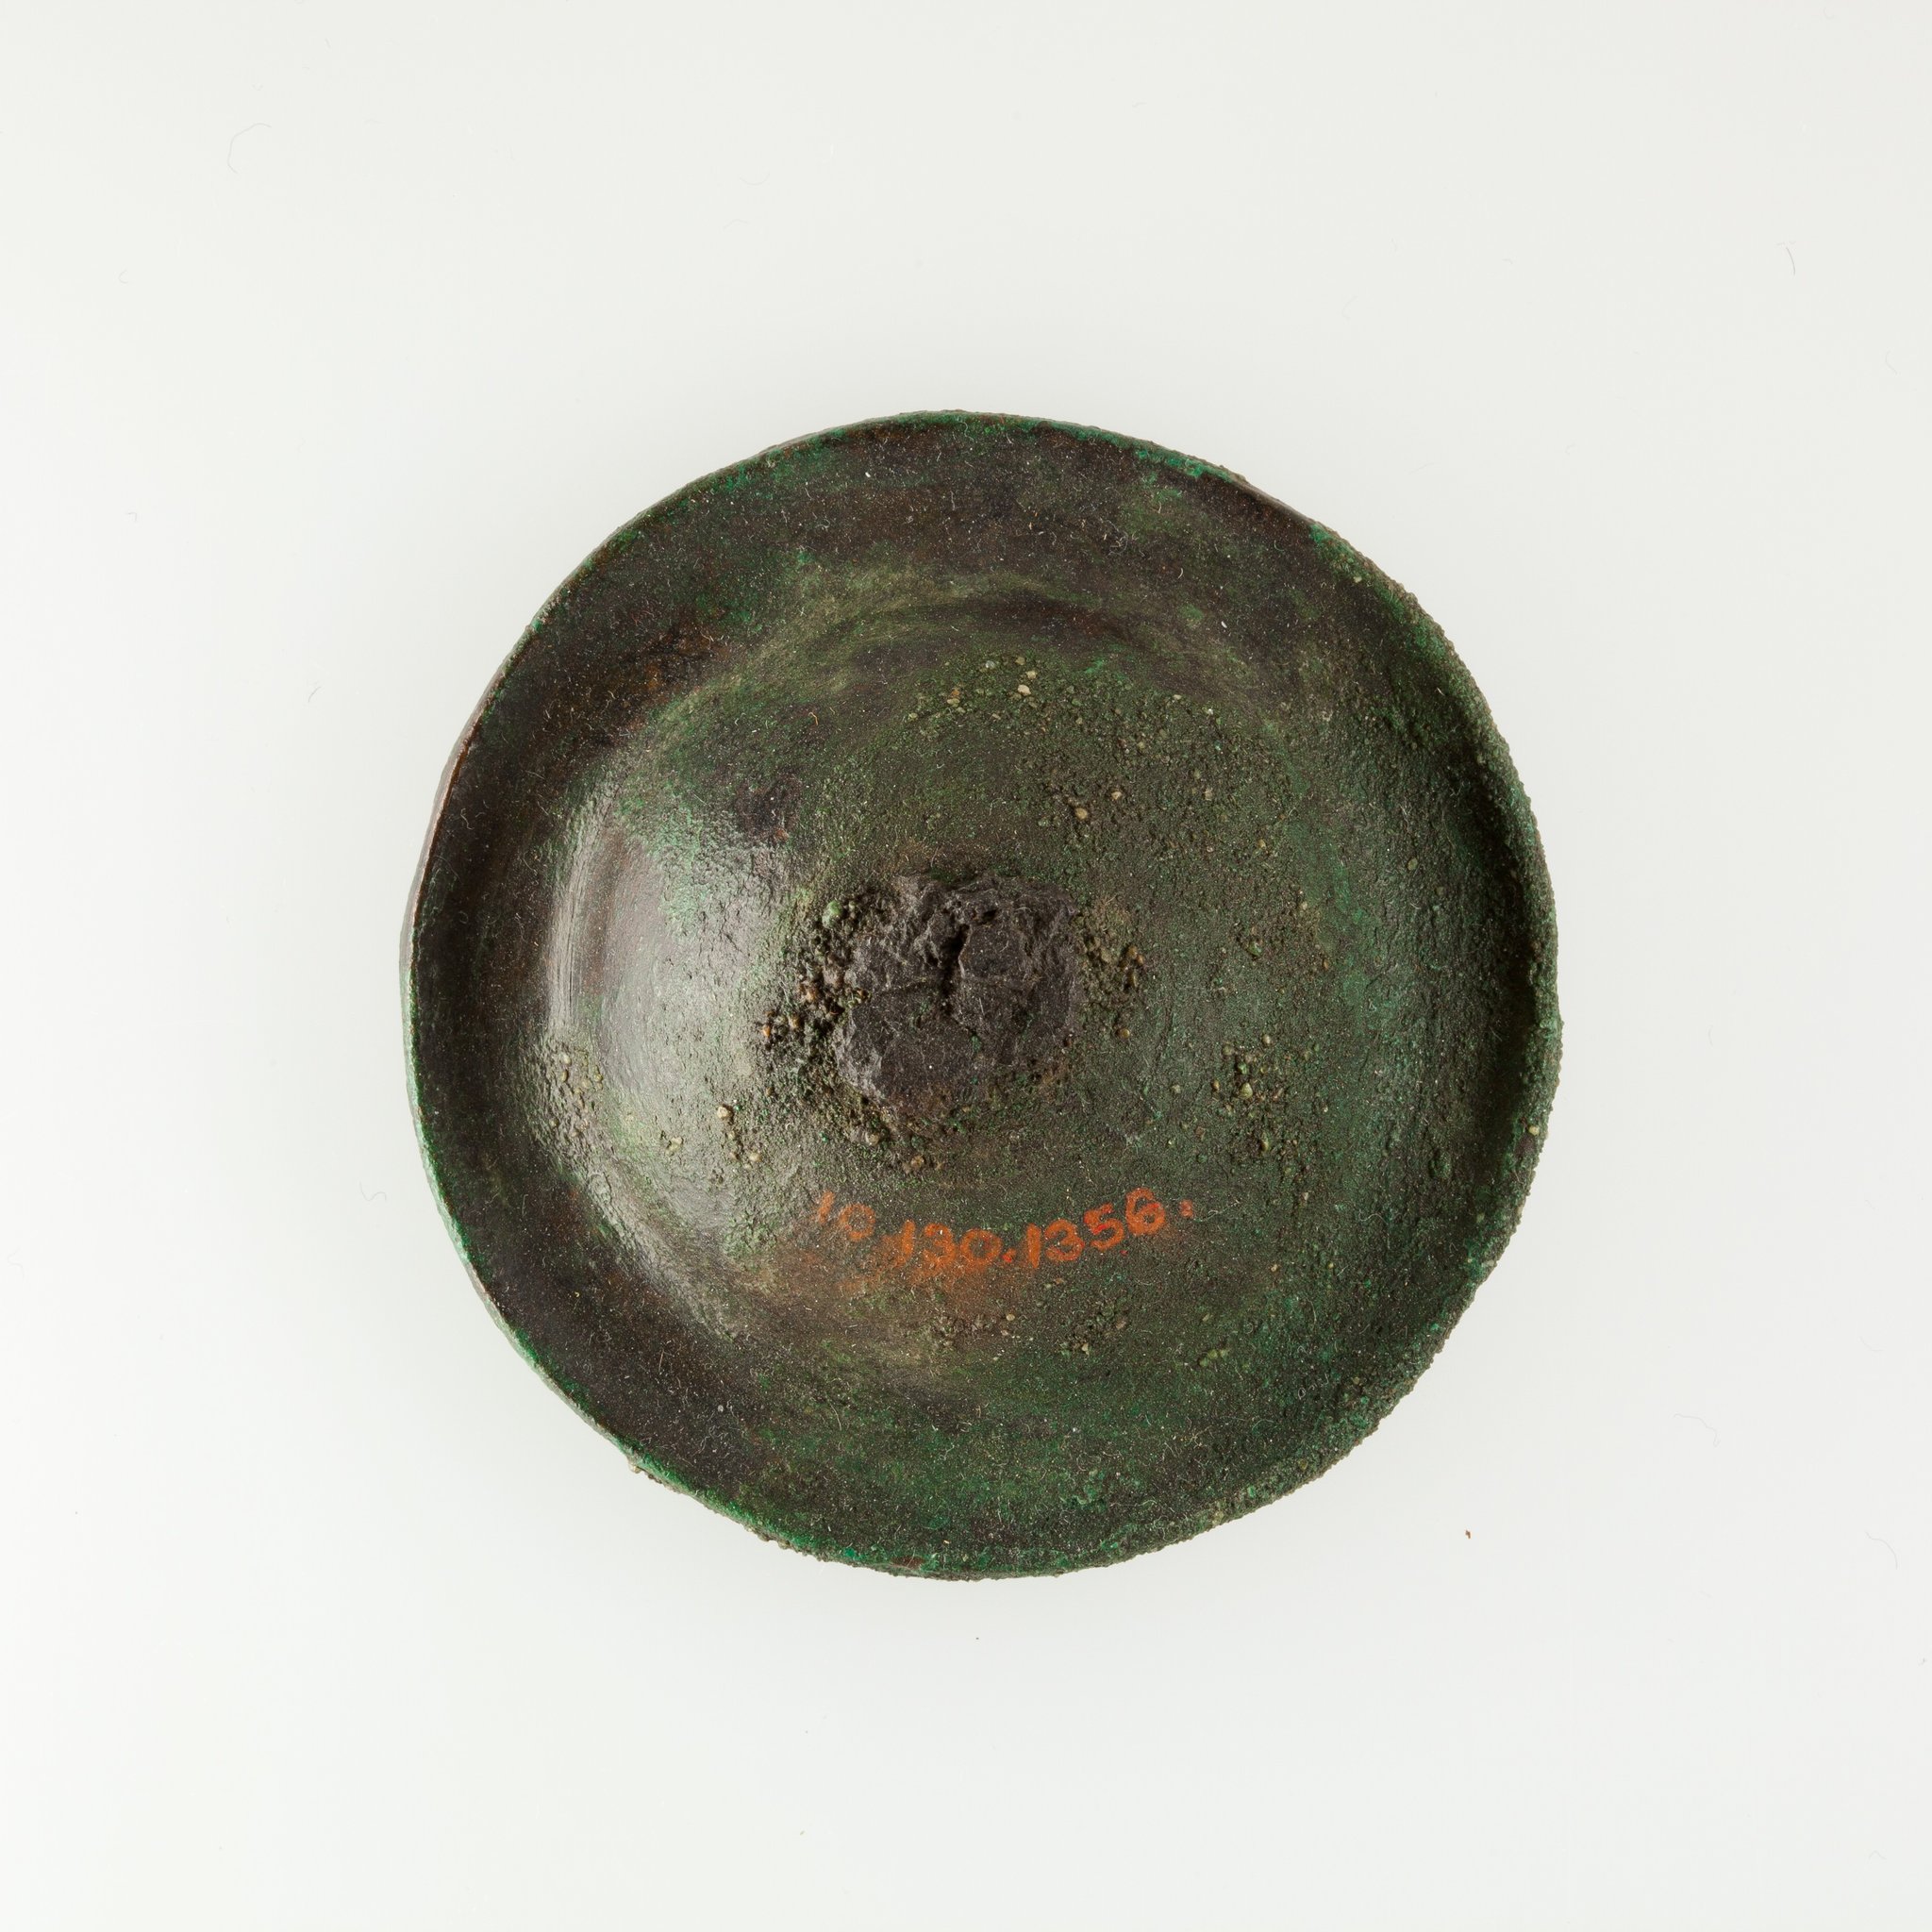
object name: music, cymbal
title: Cymbal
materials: copper alloy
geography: egypt